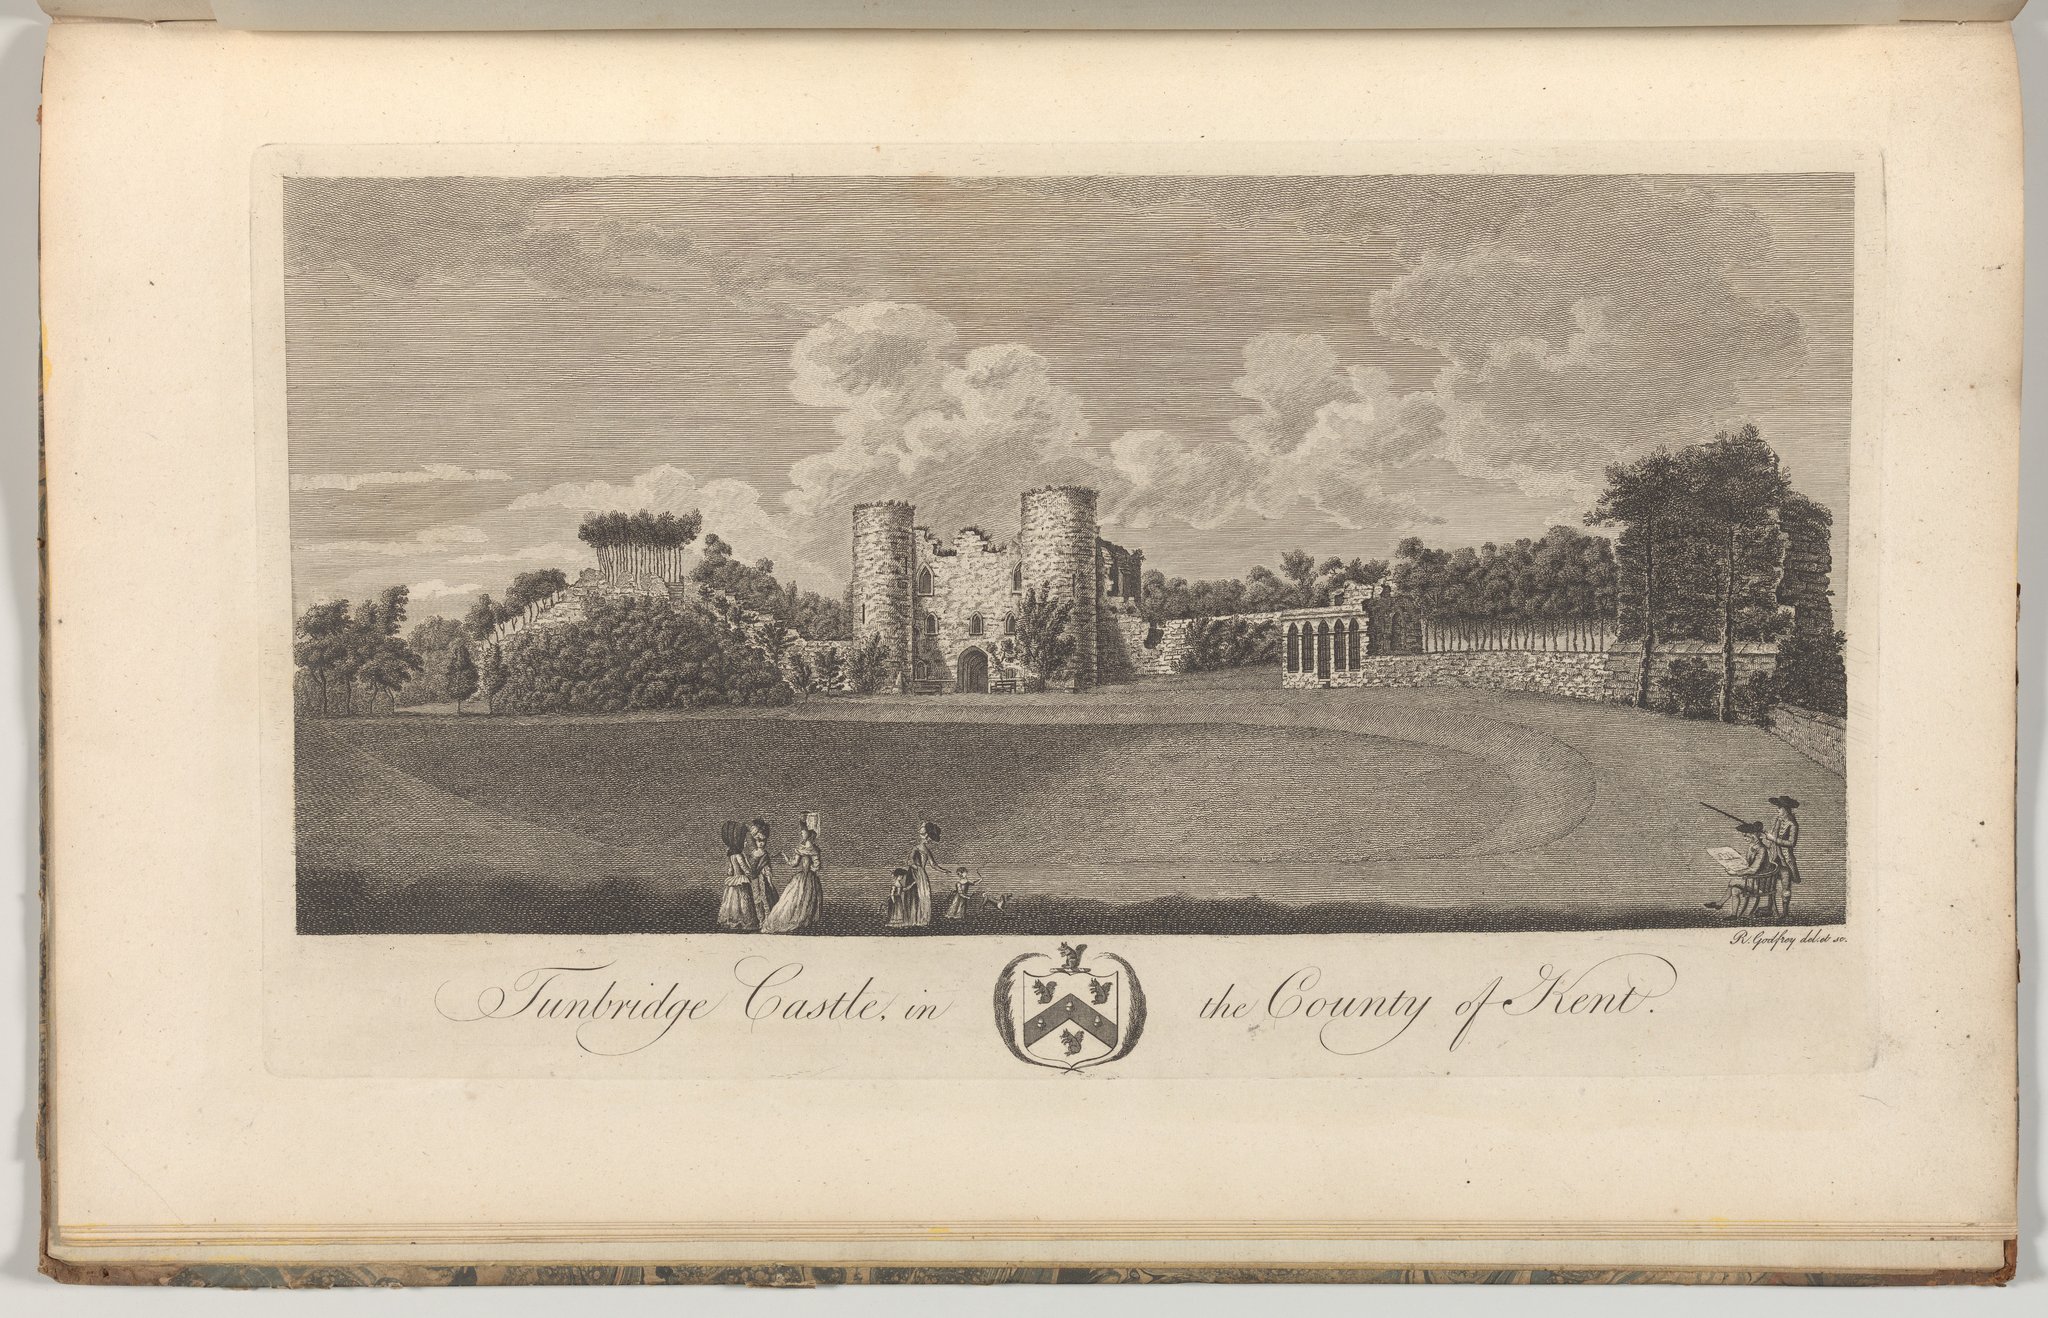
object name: print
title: Votes Place in the County of Kent, from Edward Hasted's "The History and Topographical Survey of the County of Kent", vols. 1-3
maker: richard bernard godfrey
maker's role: artist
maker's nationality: british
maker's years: 1728-1795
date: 1777-1790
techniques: engraving, etching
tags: castles,men,women,landscapes,coat of arms